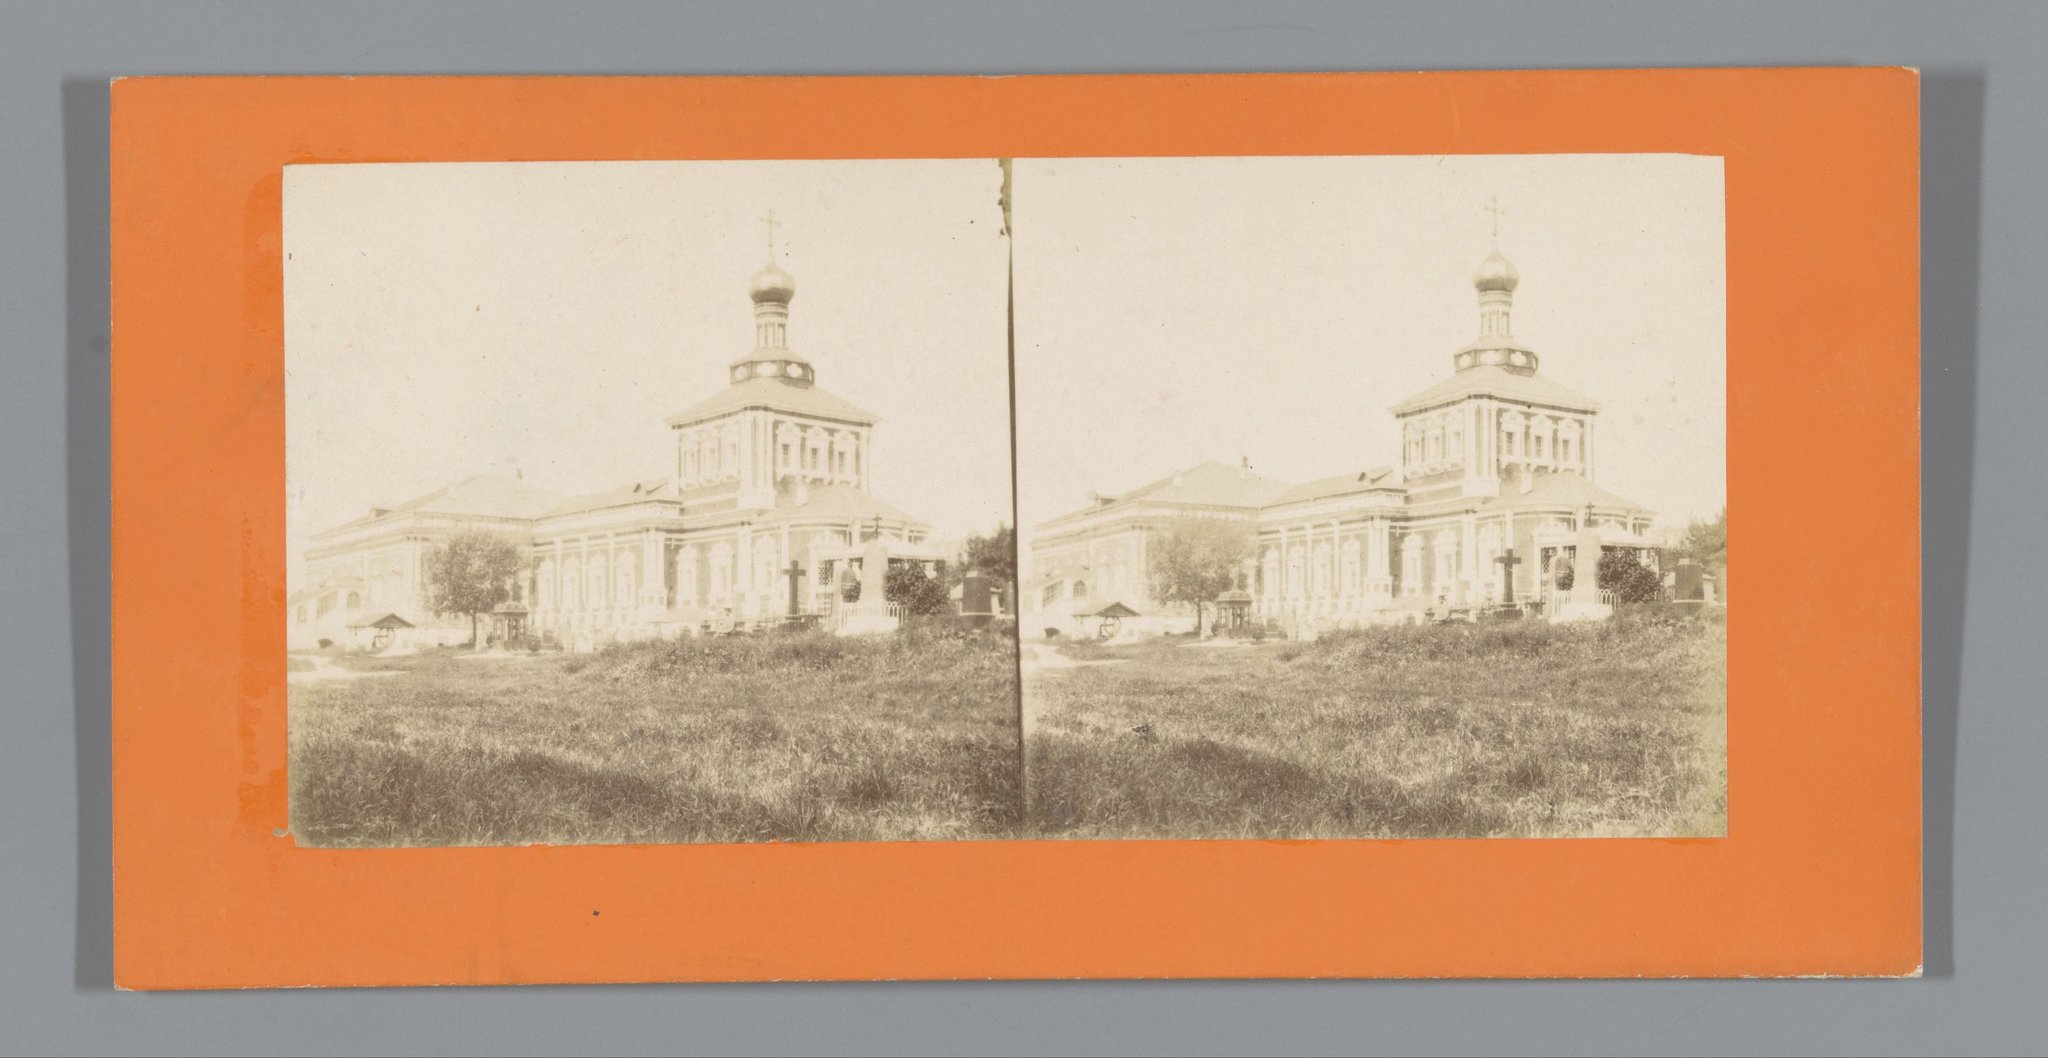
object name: stereograph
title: Binnenplaats van het Novodevitsjiklooster in Moskou met zicht op de kerk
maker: Anonymous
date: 1850-1880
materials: cardboard, photographic support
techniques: albumen print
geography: moscow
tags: church (exterior), cloisters ~ monastery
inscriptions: inscription: ‘62 Intérieur du Couvent des Vierges Moscou’